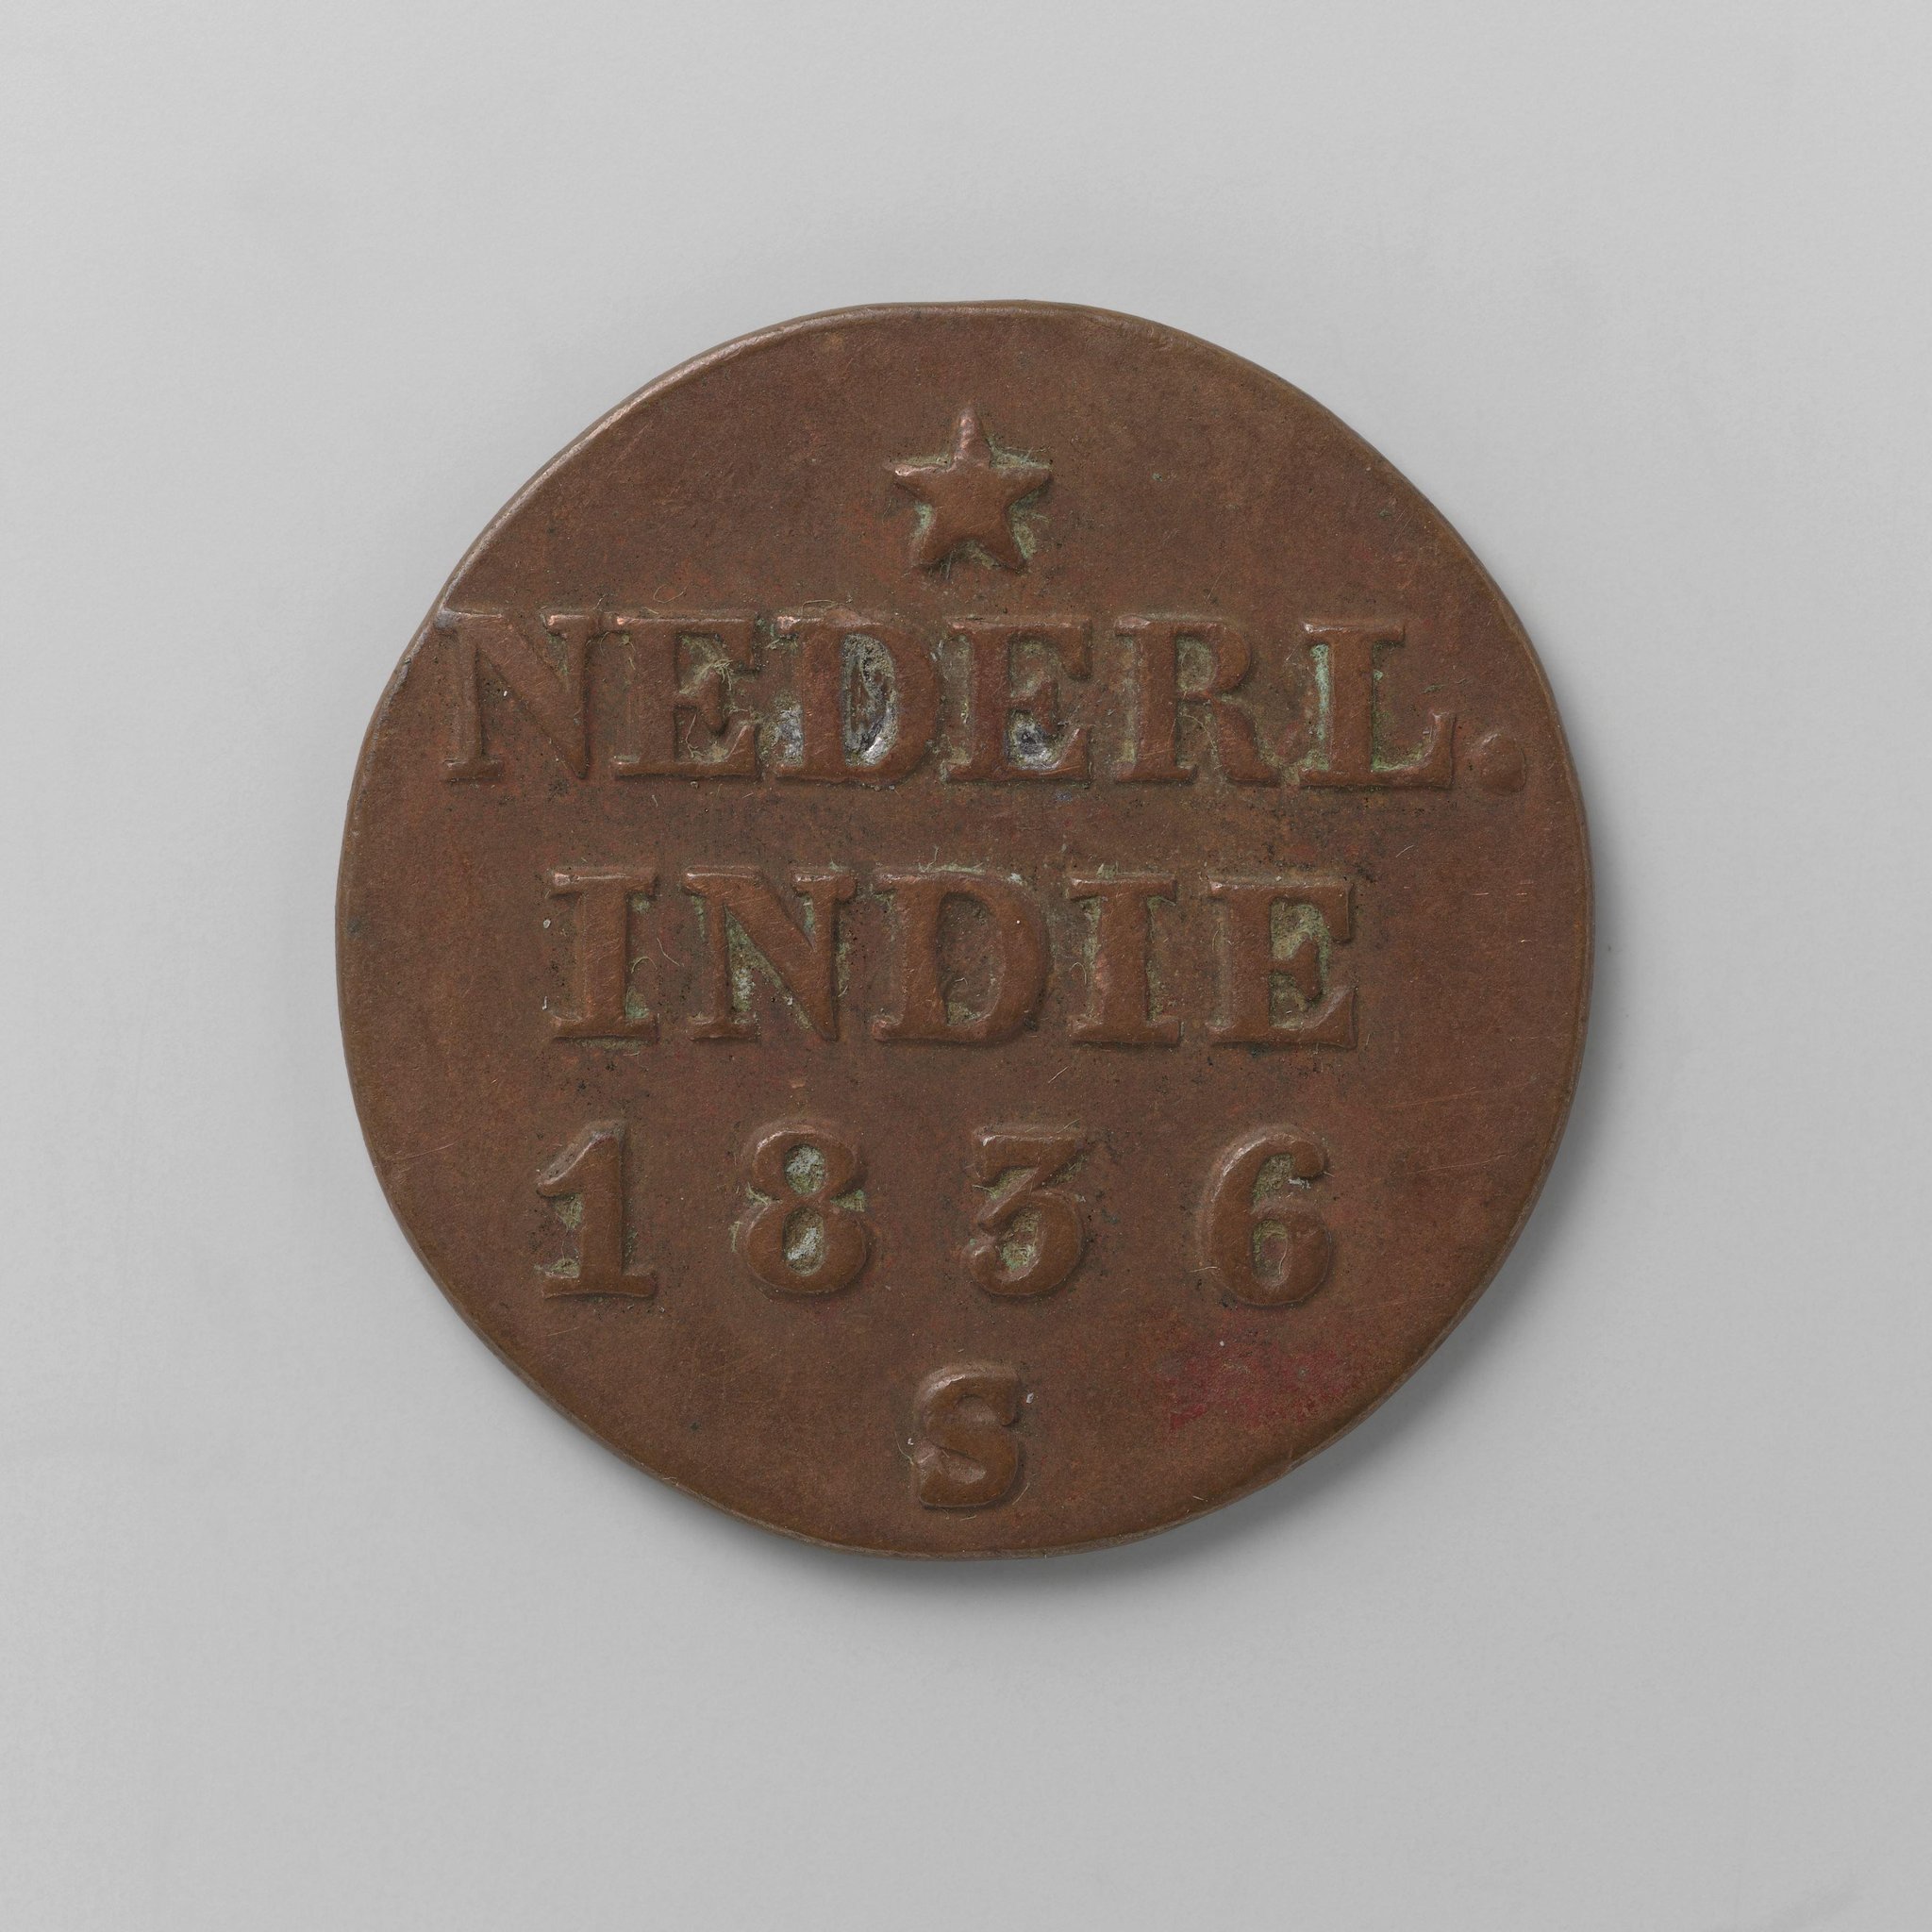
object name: coin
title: Nederlands Indië,1/4 stuiver,1836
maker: william i of the netherlands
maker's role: koning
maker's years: 1772-1843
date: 1836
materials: copper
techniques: striking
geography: utrecht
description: Koperen munt. Voorzijde: tussen waarde-aanduiding 1/4 St. gekroond rijkswapenschild. Keerzijde: tweeregelig opschrift, waarboven muntteken en waaronder jaartal. Daaronder muntmeesterteken S [=Suermondt]. Gladde rand.